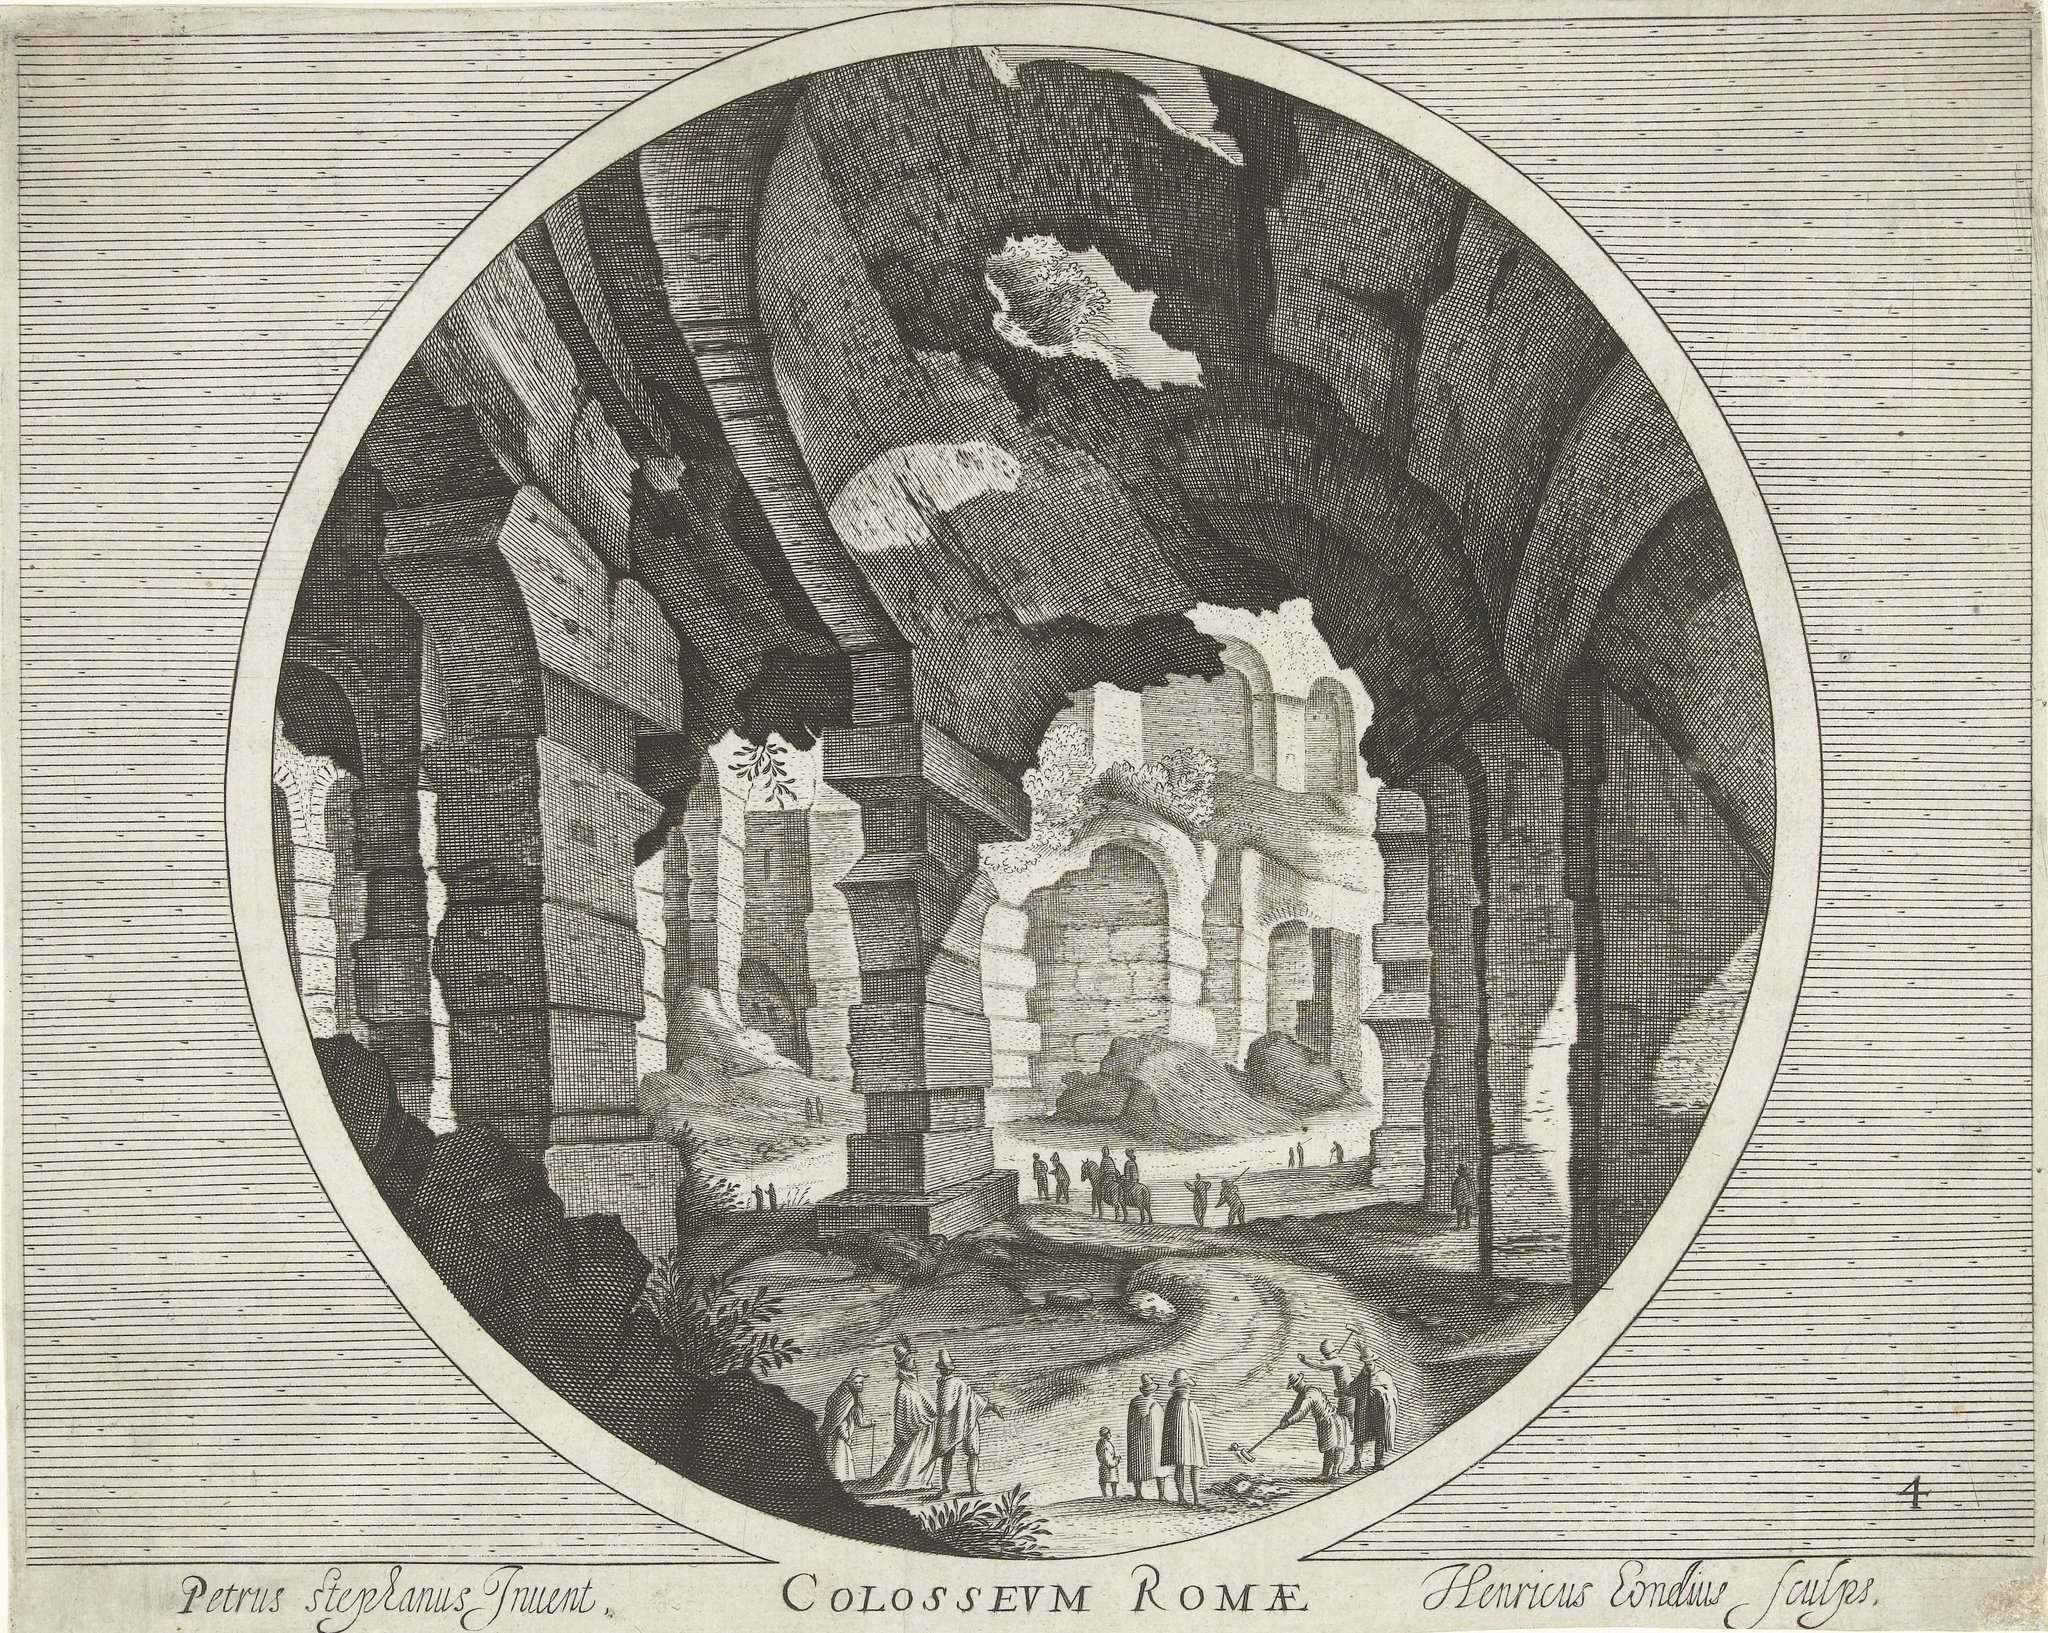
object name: print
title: Colosseum, met golfspelers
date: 1600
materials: paper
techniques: engraving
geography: the hague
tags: ruin of a building ~ architecture, amphitheatre, golf, rome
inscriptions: collector's mark: Lugt 2228, collector's mark: Lugt 2028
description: Gezicht in het Colosseum met op de voorgrond een paar golfspelers. Op de achtergrond twee mannen op een ezel. Prent uit een serie van zes met voorstellingen van Romeinse ruïnes.